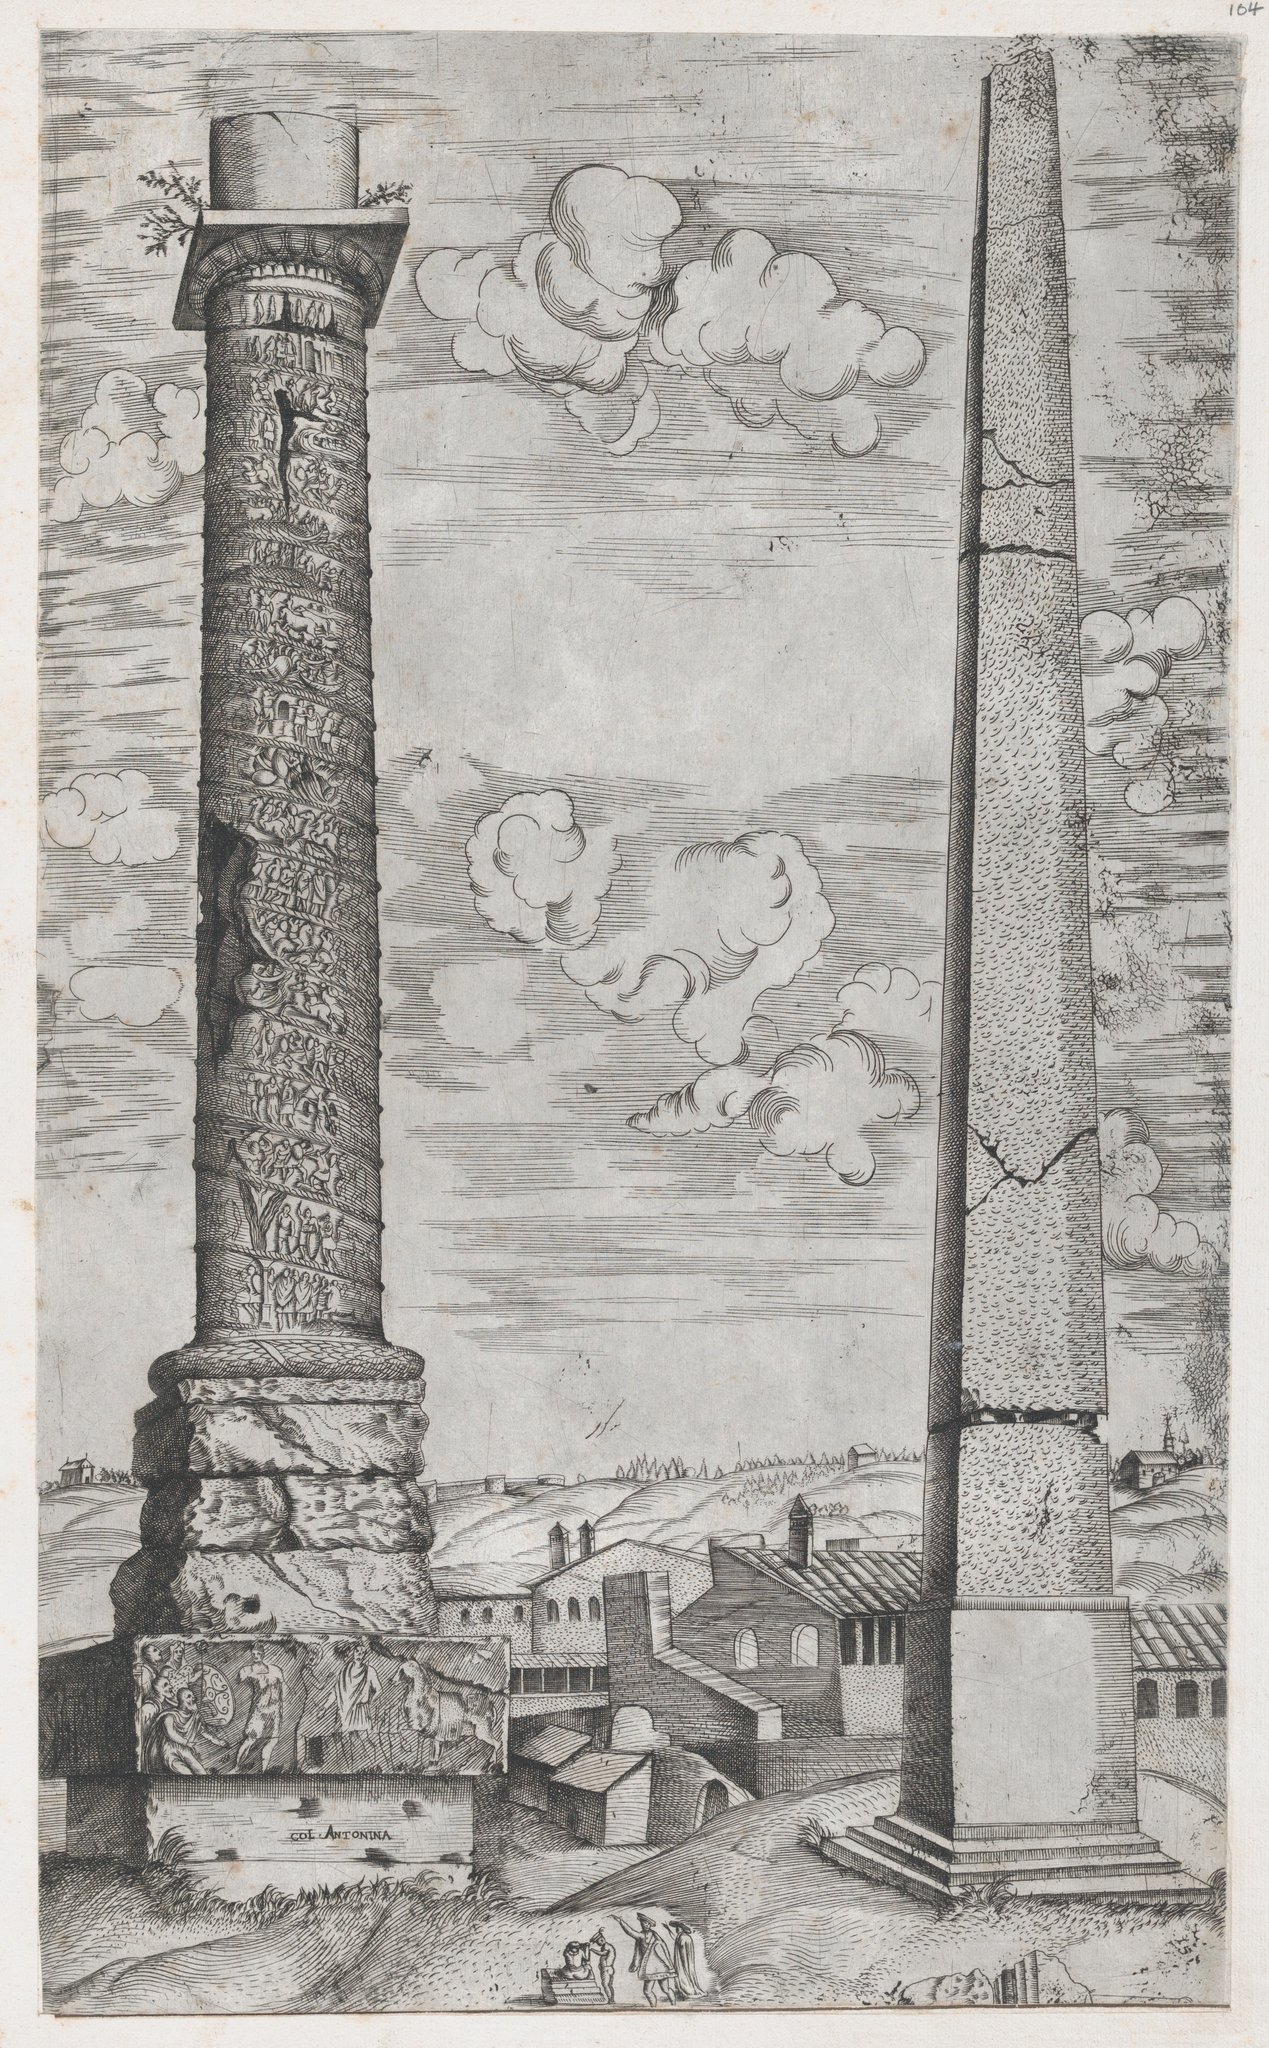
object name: print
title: Column of Antoninus and a Roman Obelisk, from "Speculum Romanae Magnificentiae"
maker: Anonymous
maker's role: artist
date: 1501-1600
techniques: etching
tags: architecture,columns,obelisks,rome